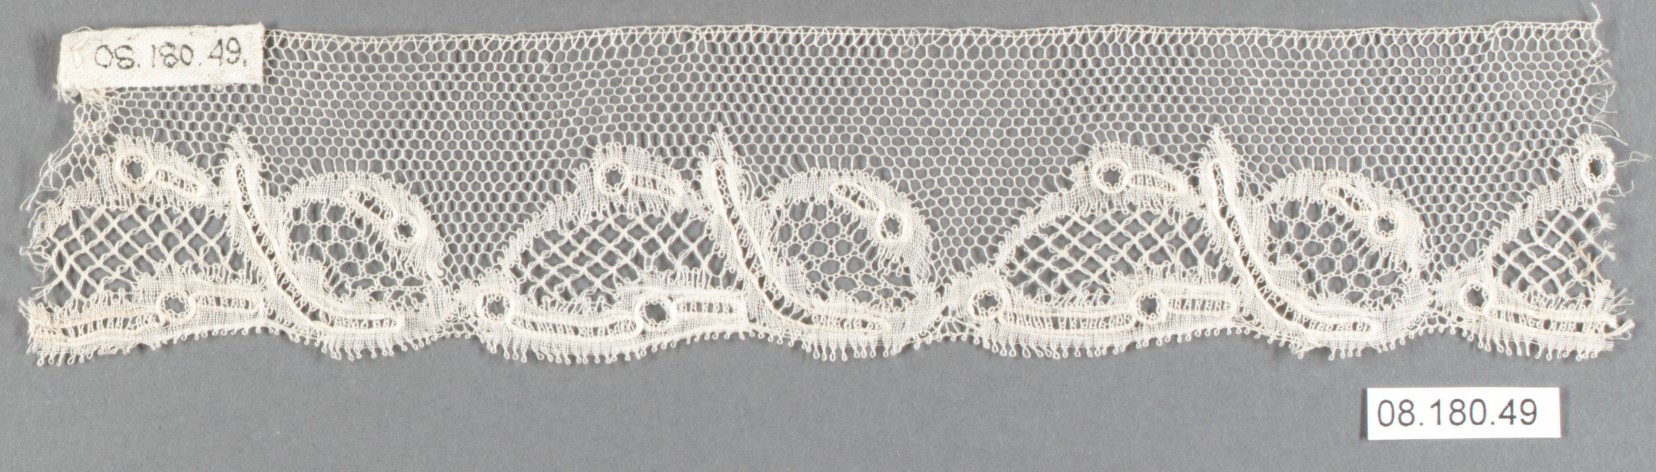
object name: fragment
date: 1801-1900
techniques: lace